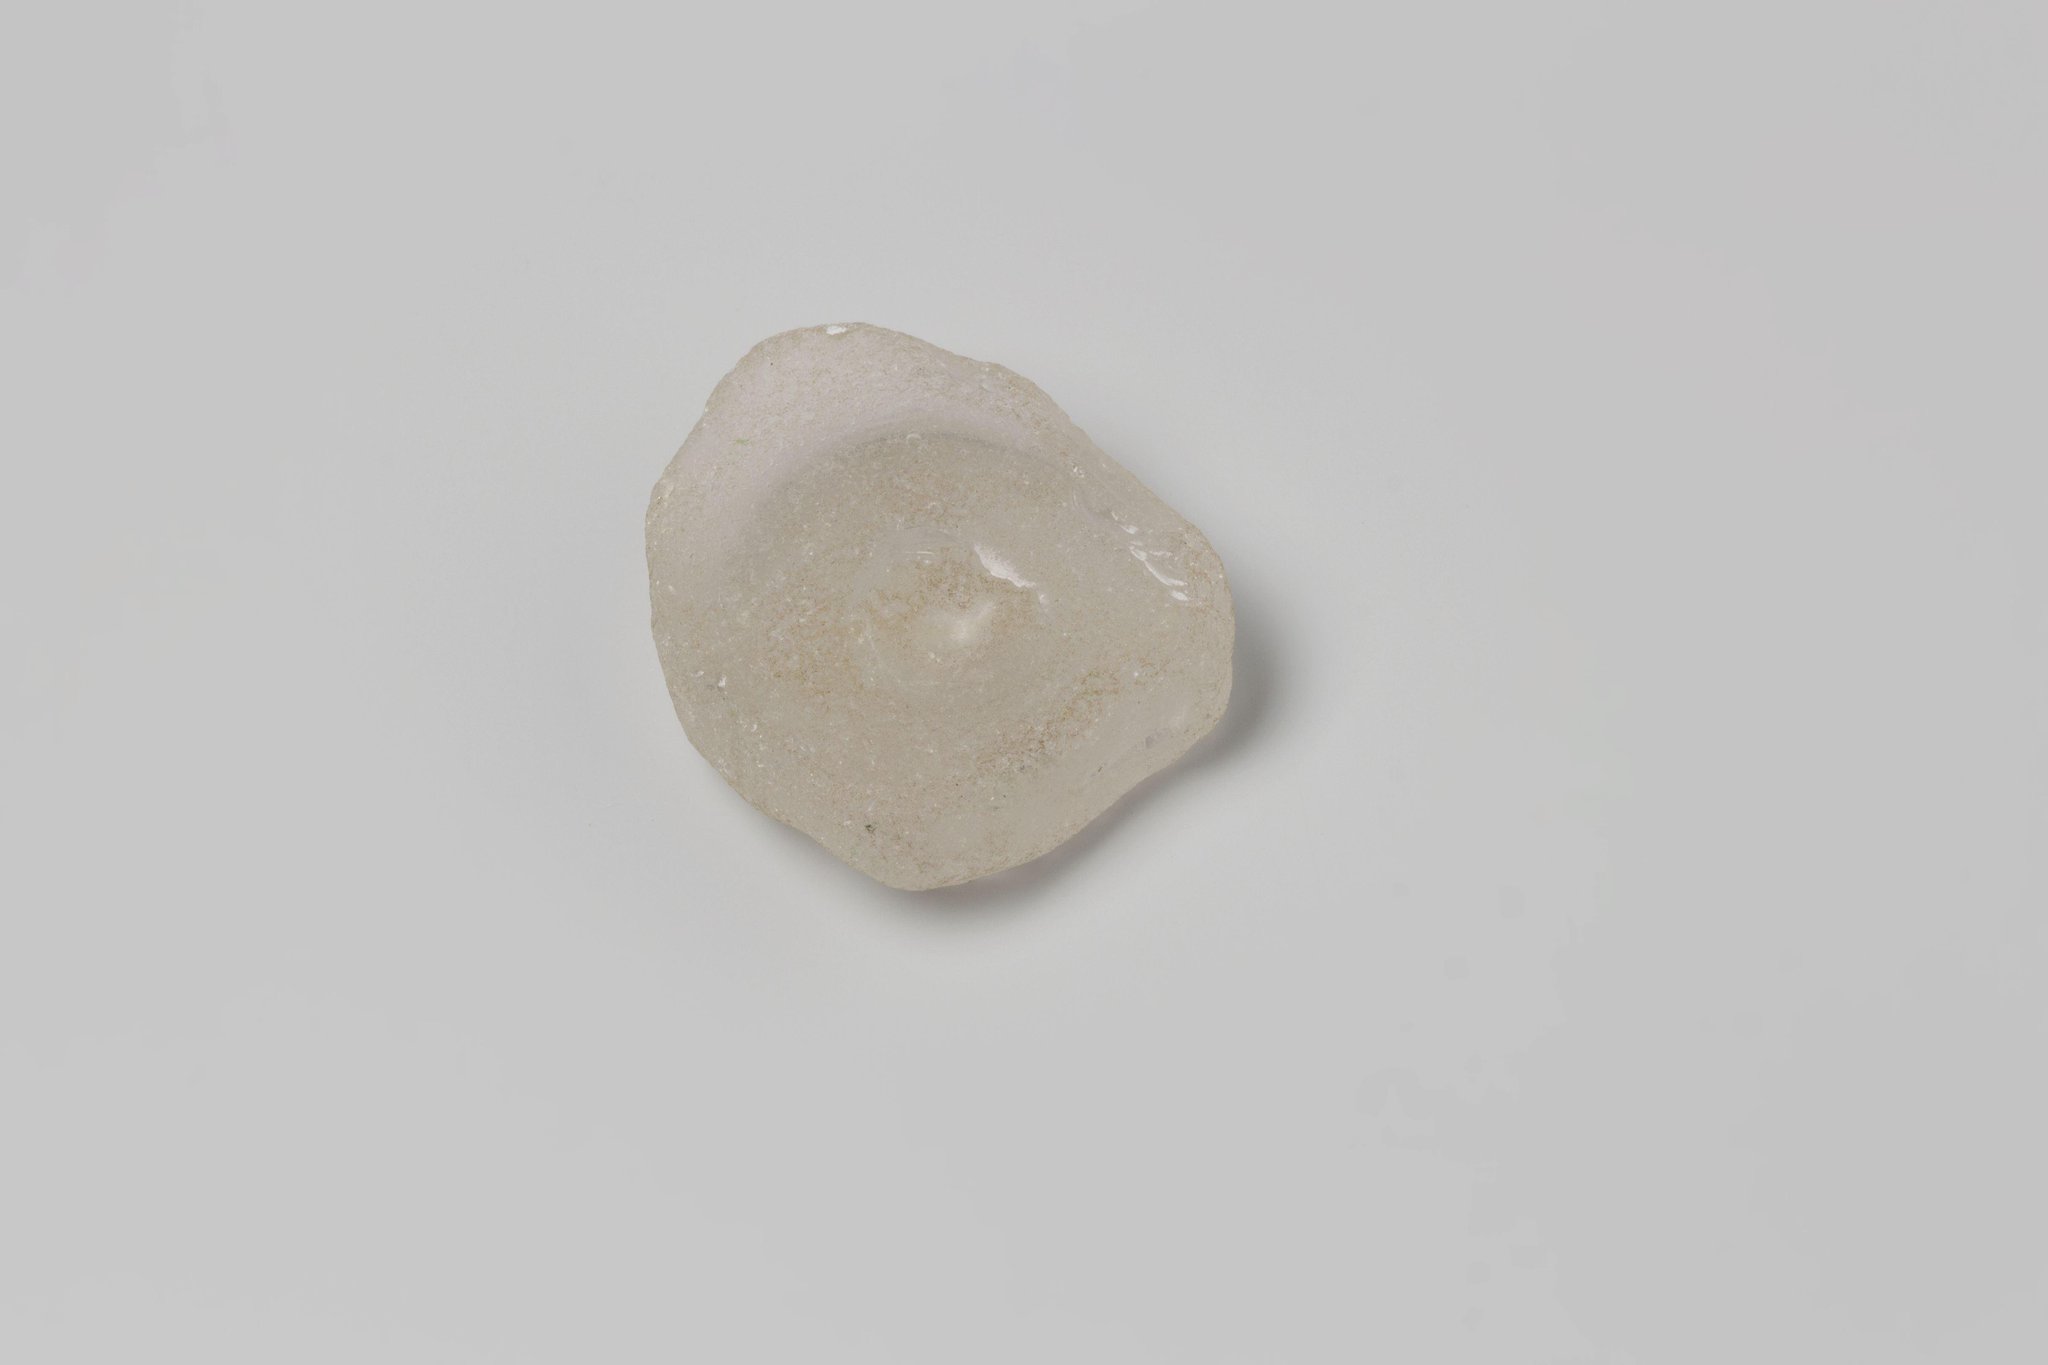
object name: foot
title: Fragment voet van vaatwerk uit het wrak van de Oost-Indiëvaarder Hollandia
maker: Anonymous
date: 1700-1743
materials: glass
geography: netherlands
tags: verenigde oostindische compagnie, hollandia (schip), annet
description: Vessel part, basal feet; fragm, sim. NG 1980-27H3171, eroded.